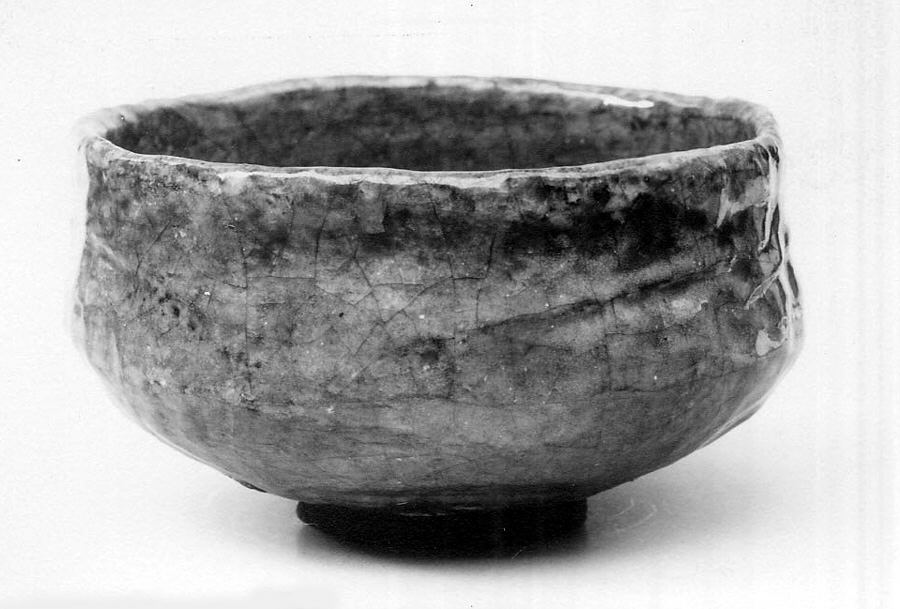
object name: teabowl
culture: japanese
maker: mitani rinsō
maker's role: artist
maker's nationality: japanese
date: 1817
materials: clay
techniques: overglaze, underglaze